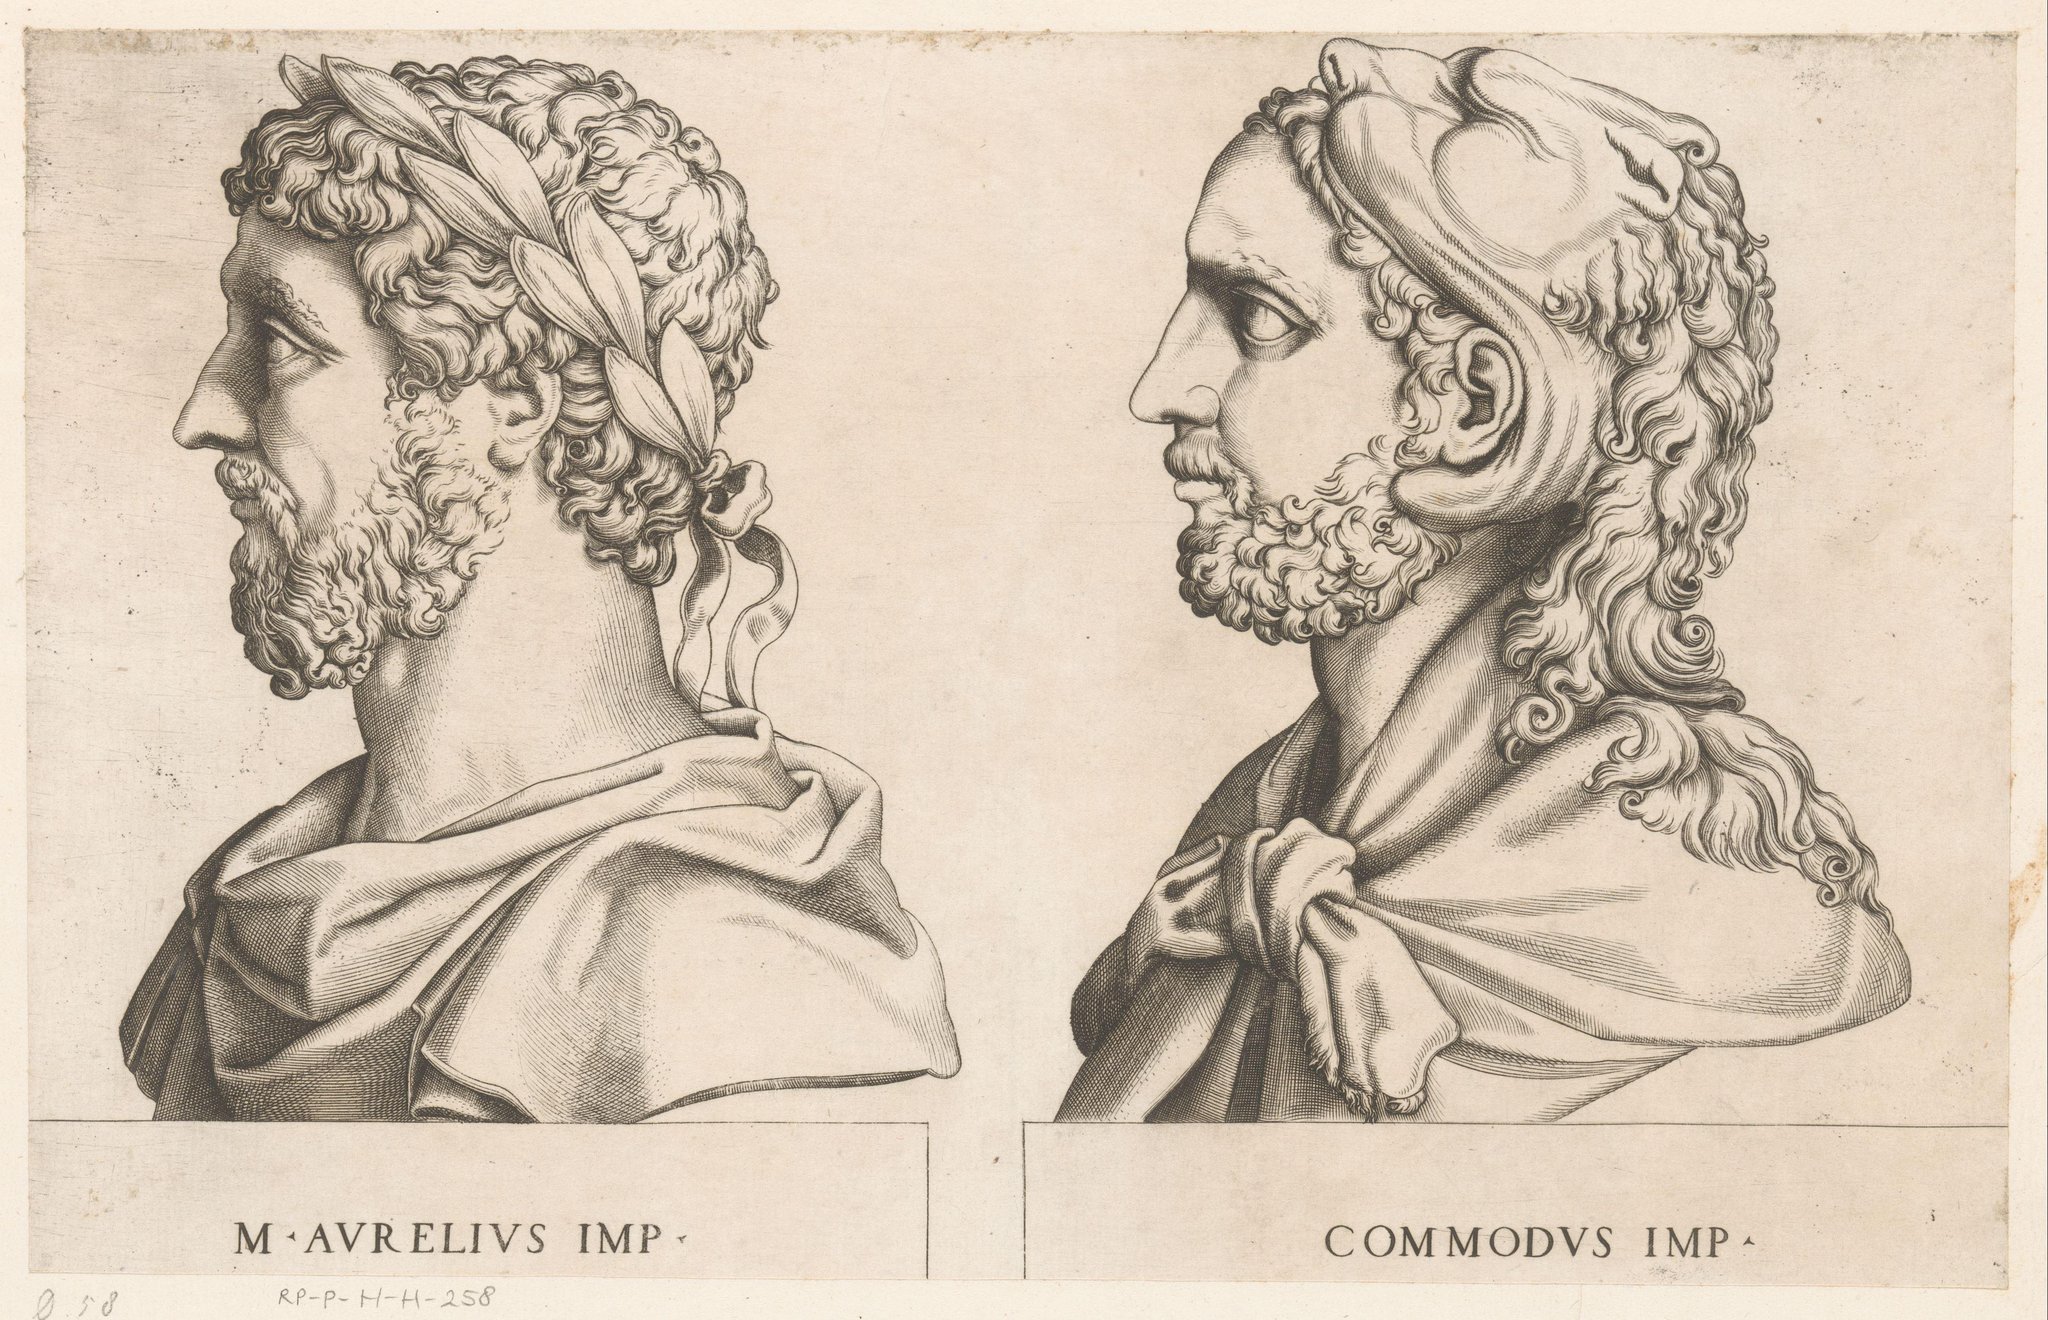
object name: print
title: Portretbustes van Romeinse keizers Marcus Aurelius en Commodus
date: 1510-1562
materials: paper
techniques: engraving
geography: rome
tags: historical persons, ruler, sovereign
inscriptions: collector's mark: Lugt 11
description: Samen met RP-P-H-H-259 op één opzetvel geplakt.